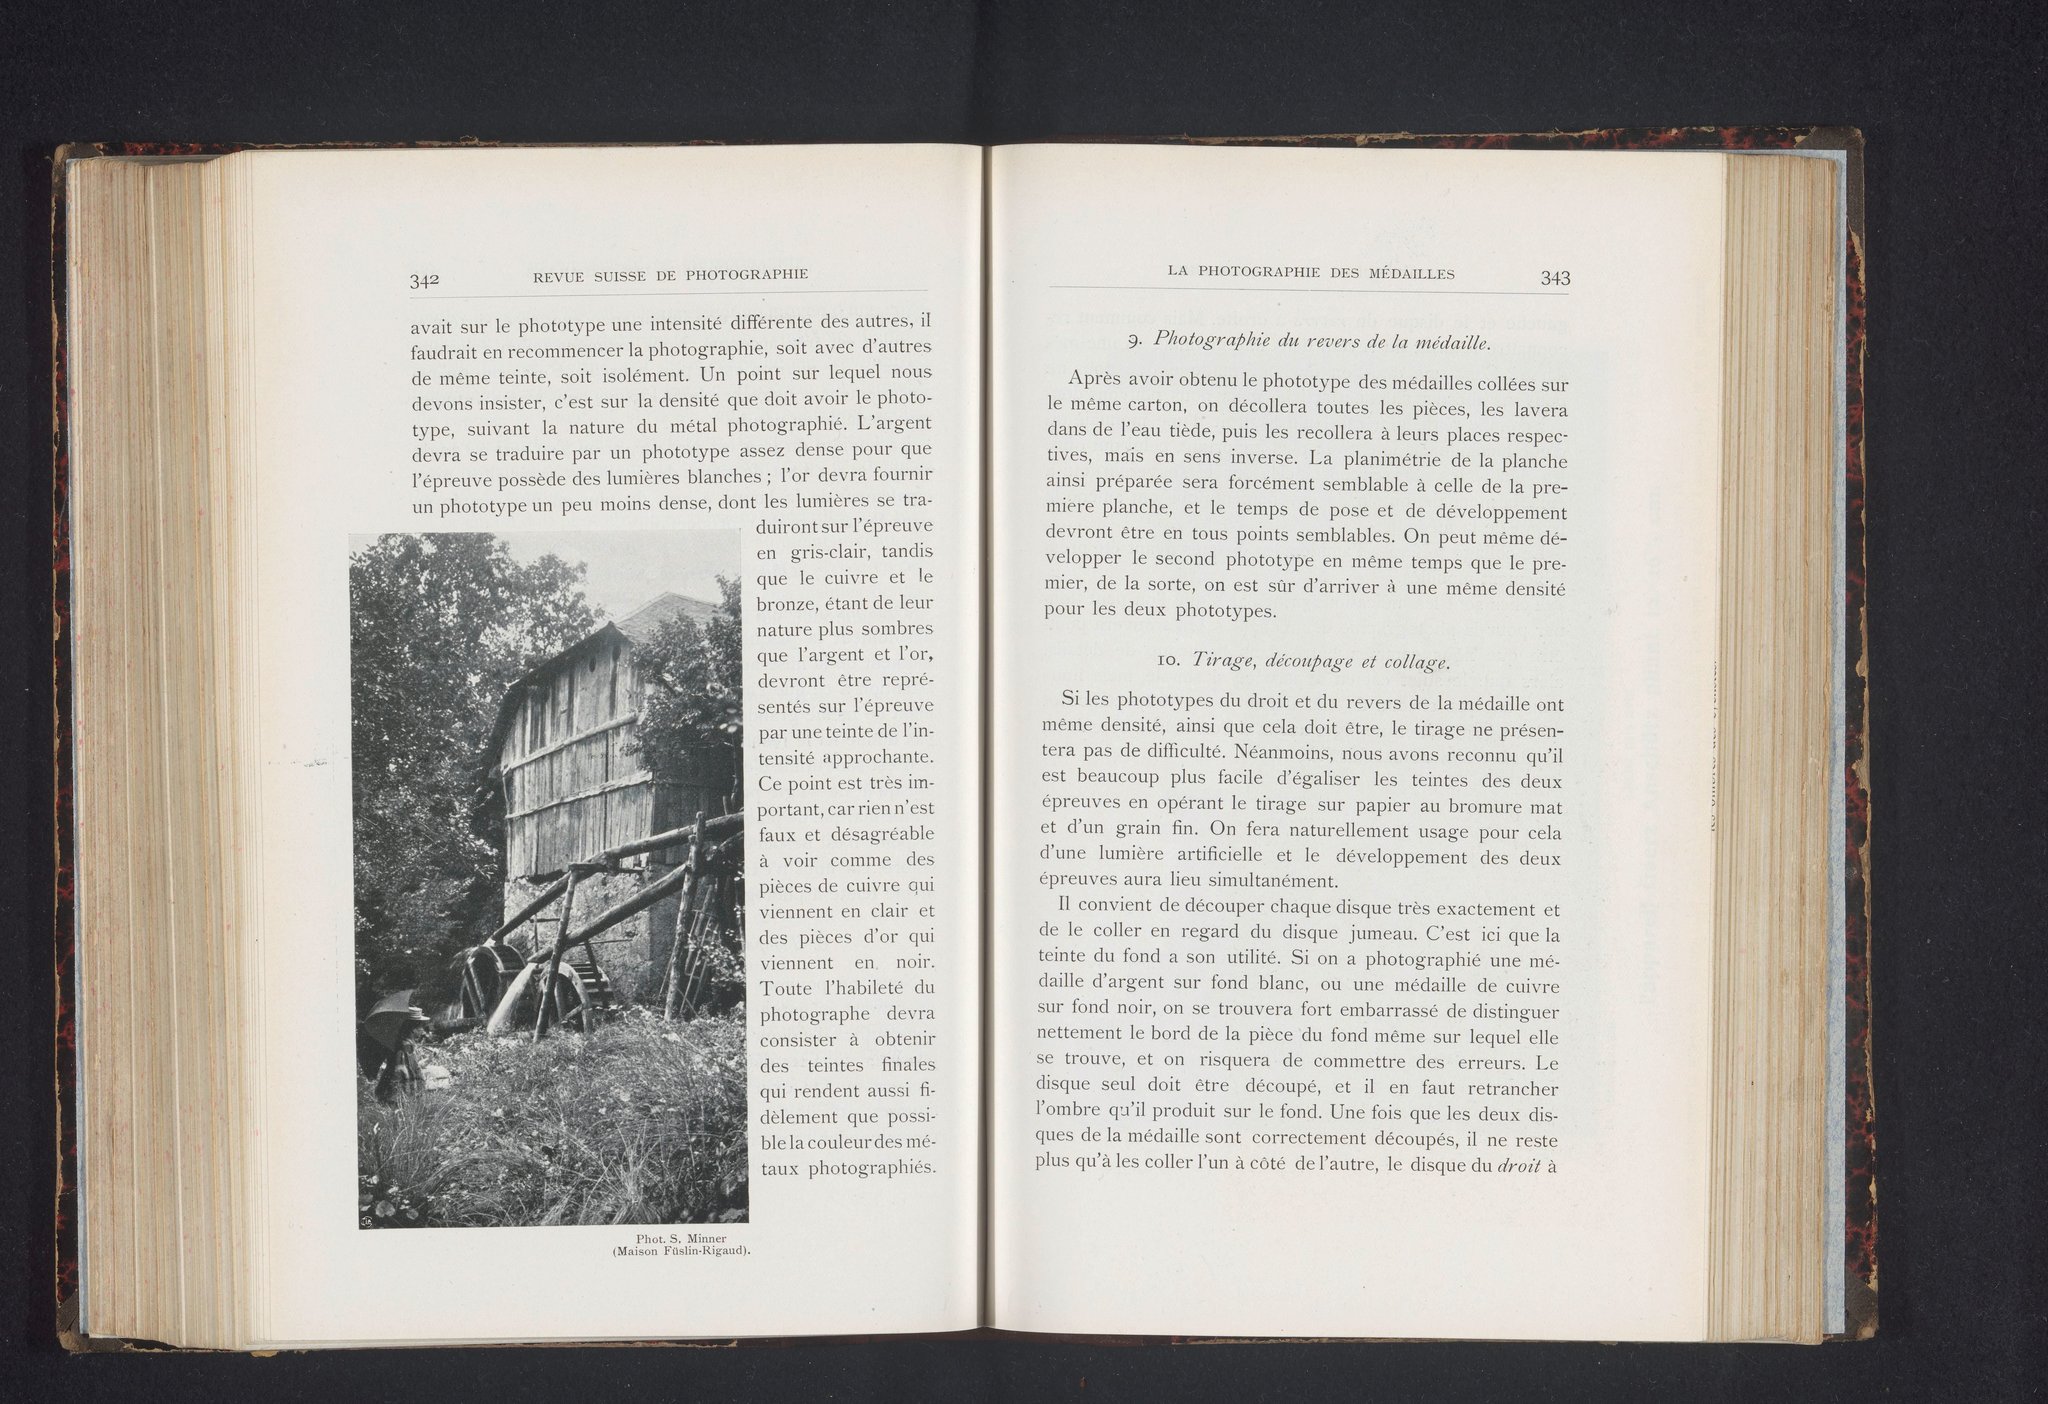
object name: page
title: Watermolen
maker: s. minner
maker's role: fotograaf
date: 1897-1902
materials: paper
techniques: autotype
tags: watermill in landscape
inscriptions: monogram: ‘C. Cie’